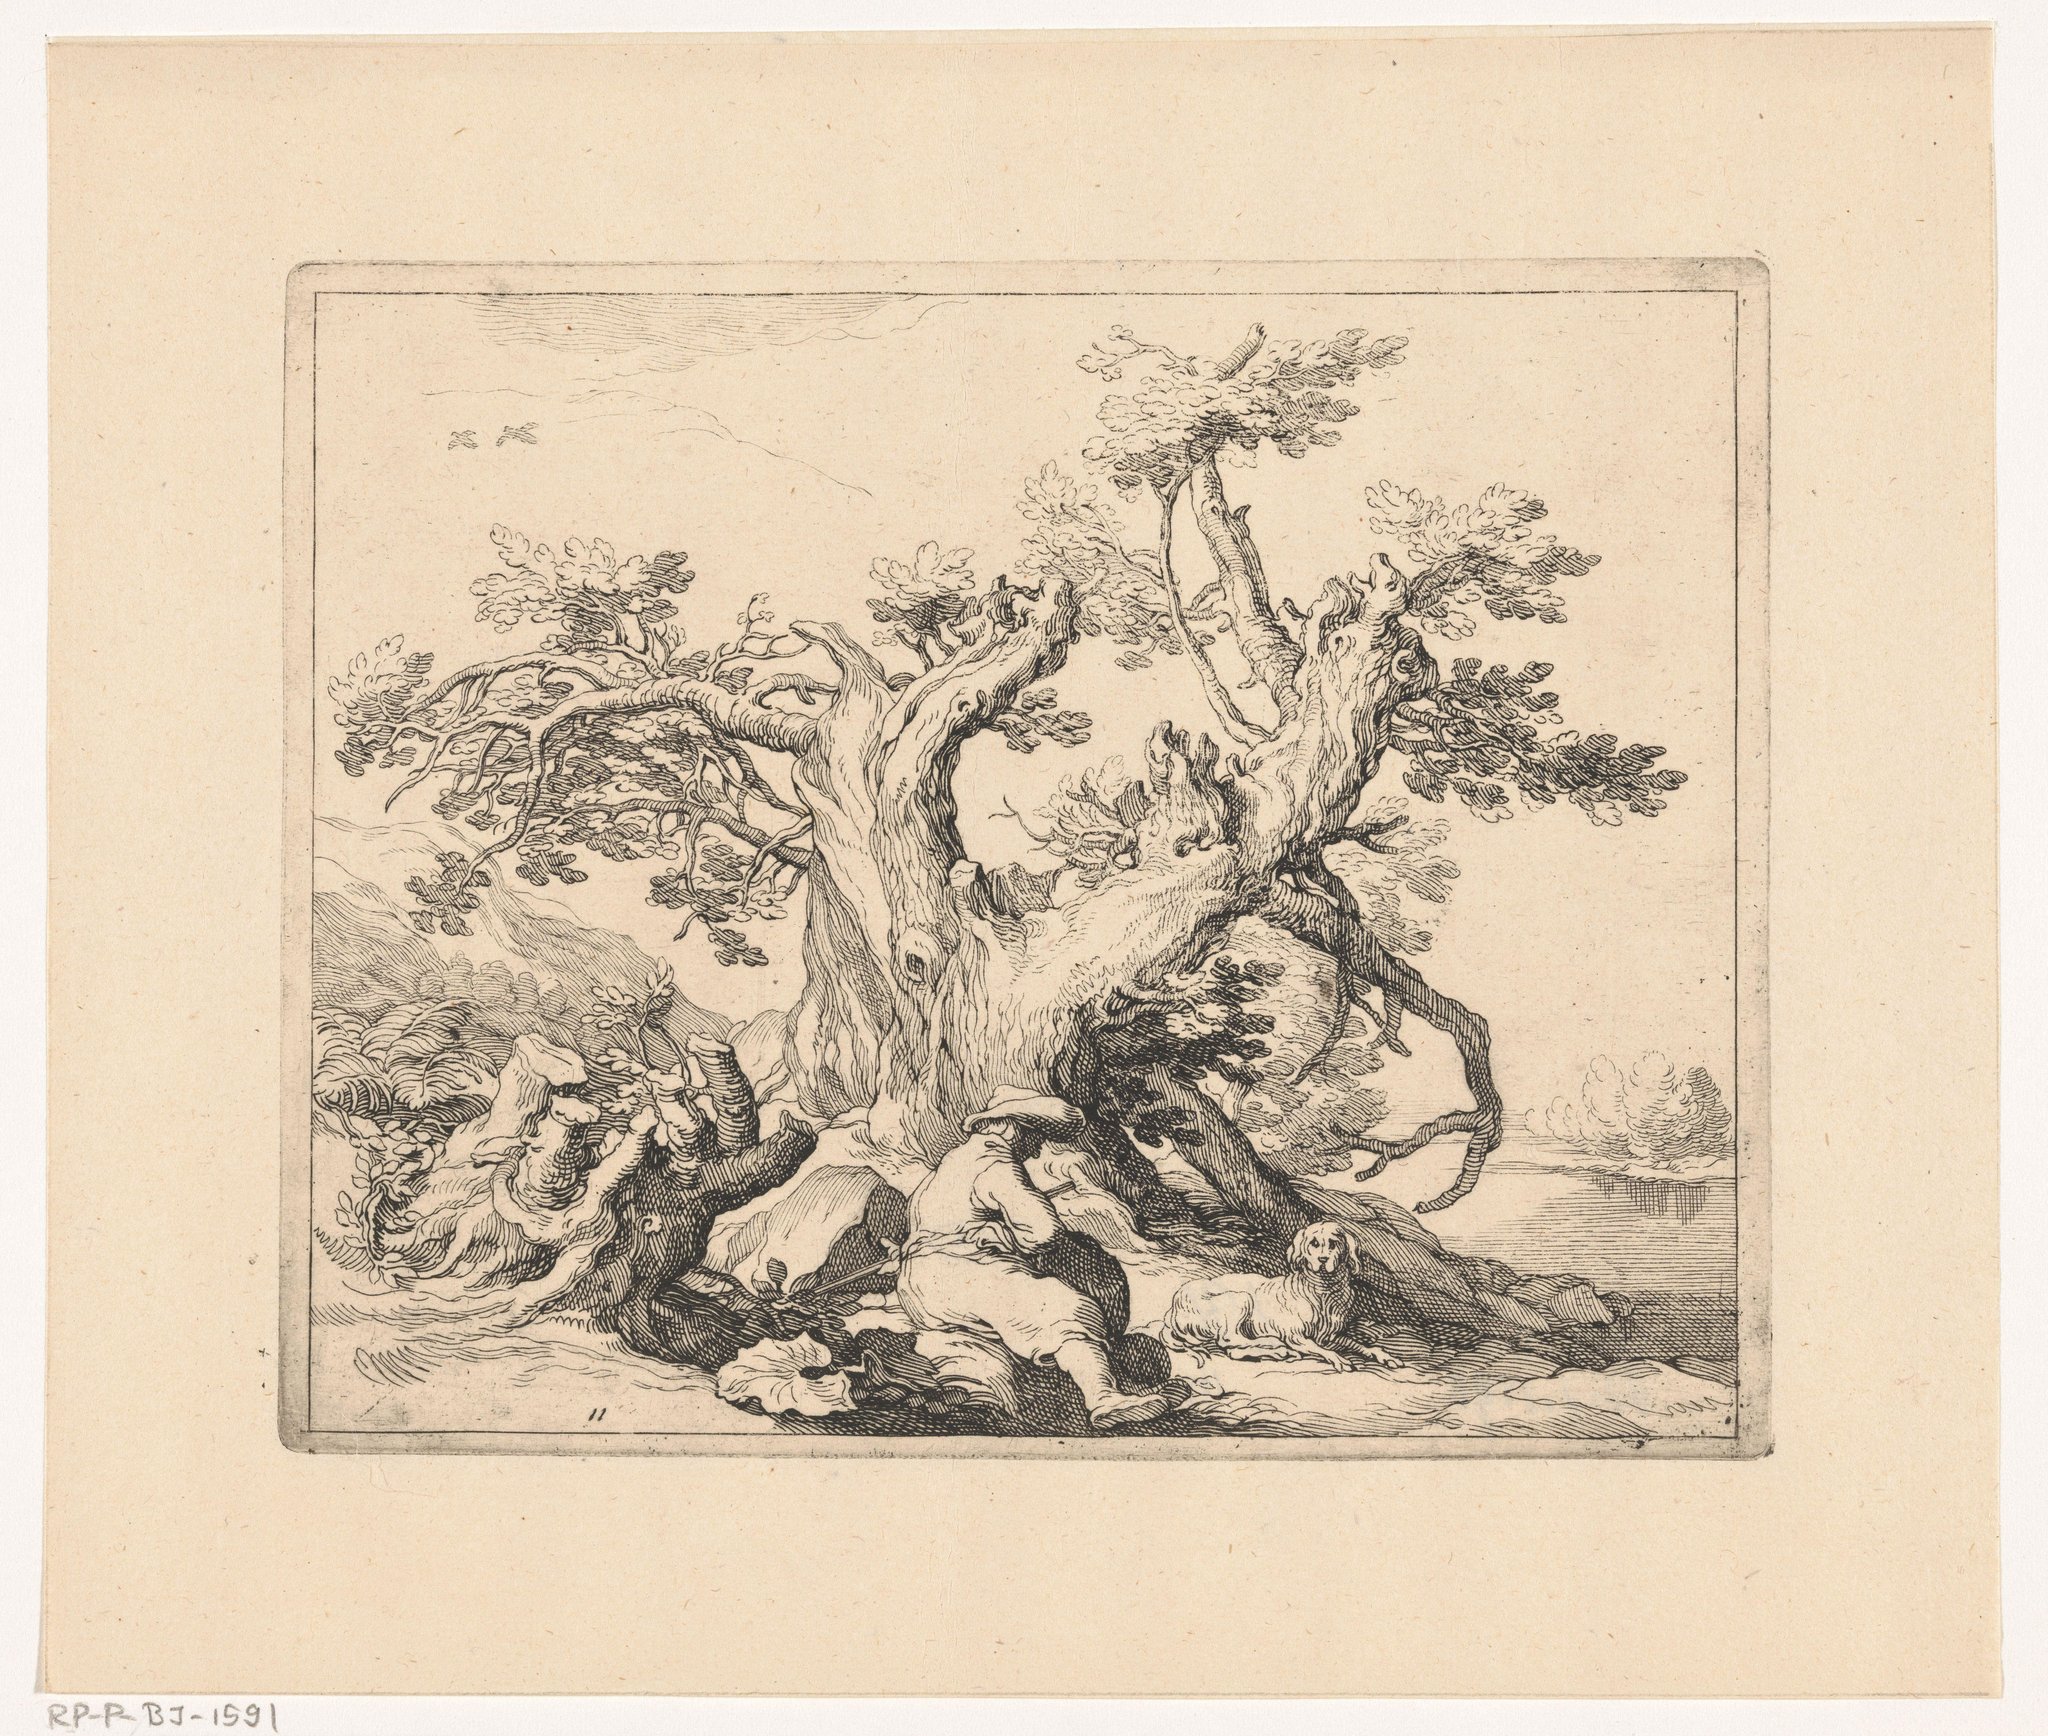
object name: print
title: Grote landschappen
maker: frederick bloemaert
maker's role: print maker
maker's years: 1614-1669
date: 1635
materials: paper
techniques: etching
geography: utrecht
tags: trees, landscapes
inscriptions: collector's mark: Lugt 240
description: Een man en zijn hond rusten uit voor een knoestige boom met veel gebladerte.